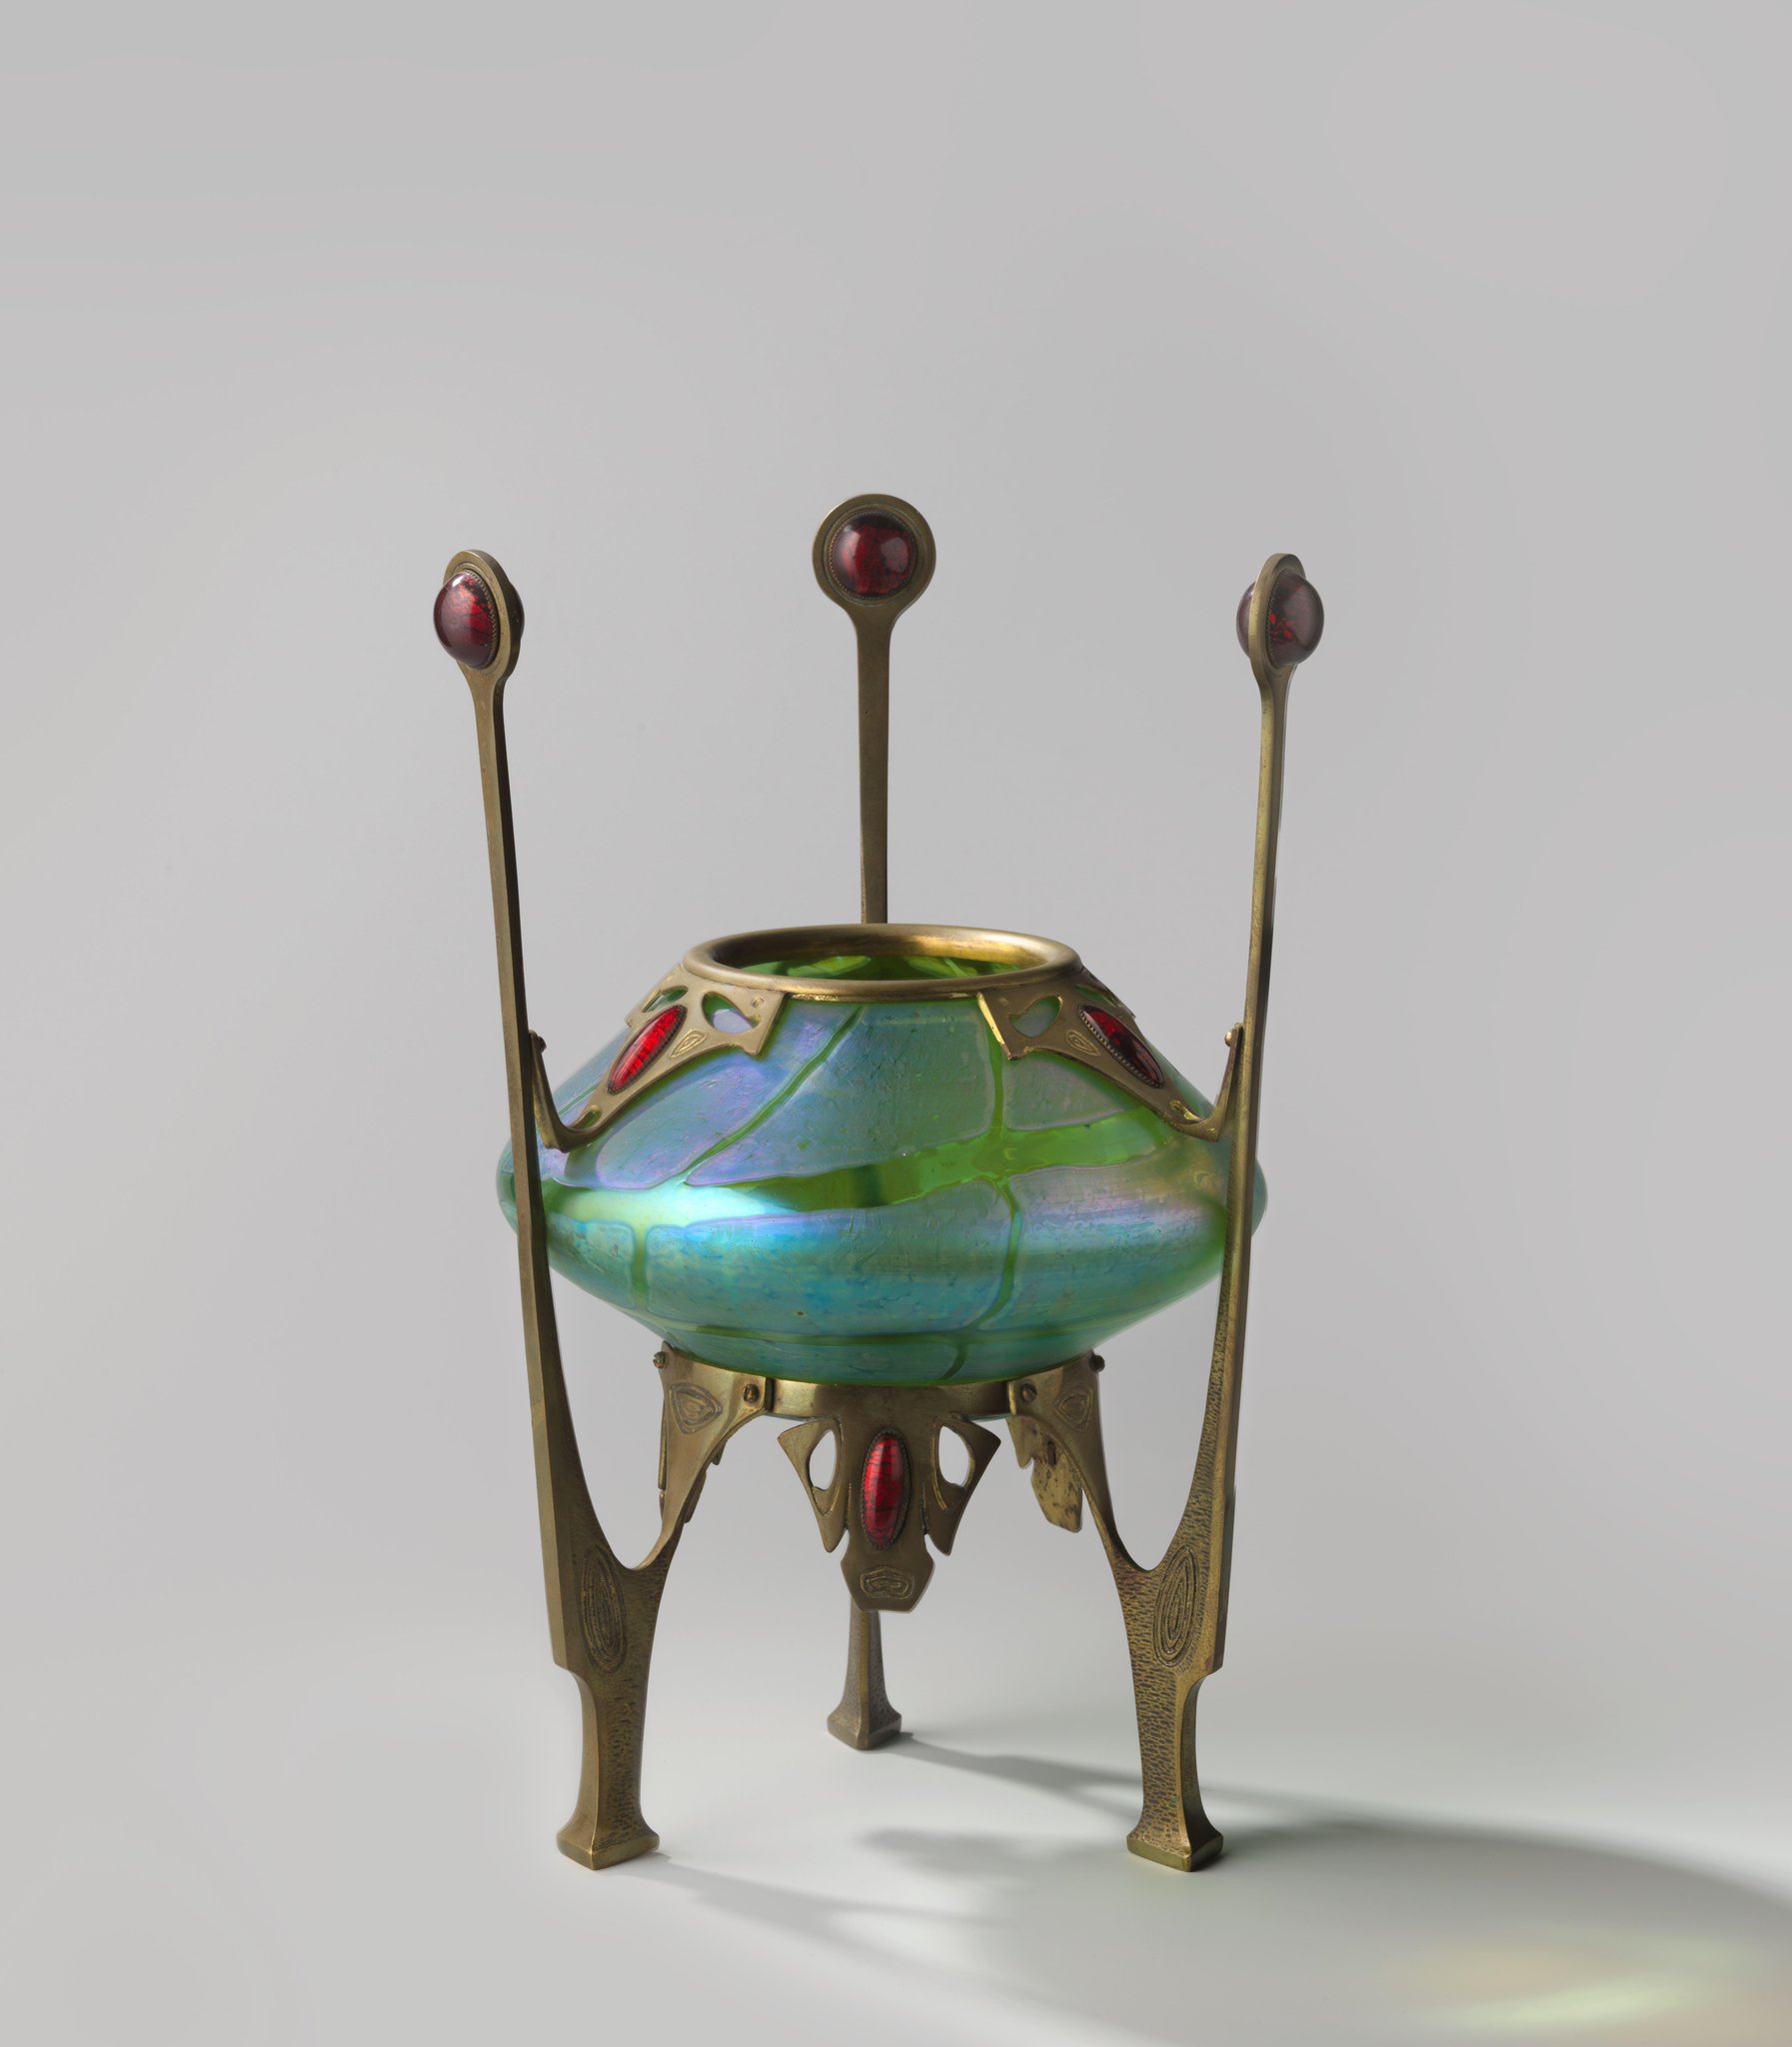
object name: vase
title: Vaas met geëtste vlakken en irisering in verguld messing montuur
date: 1900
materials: brass, glass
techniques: etching, gilding, glassblowing, iridescence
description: Dubbelconisch lichaam met geëtste vlakken en irisering. Montuur van verguld messing, gedecoreerd met drie bollen en zes medaillons van rood glas met meegeblazen bladgoud.